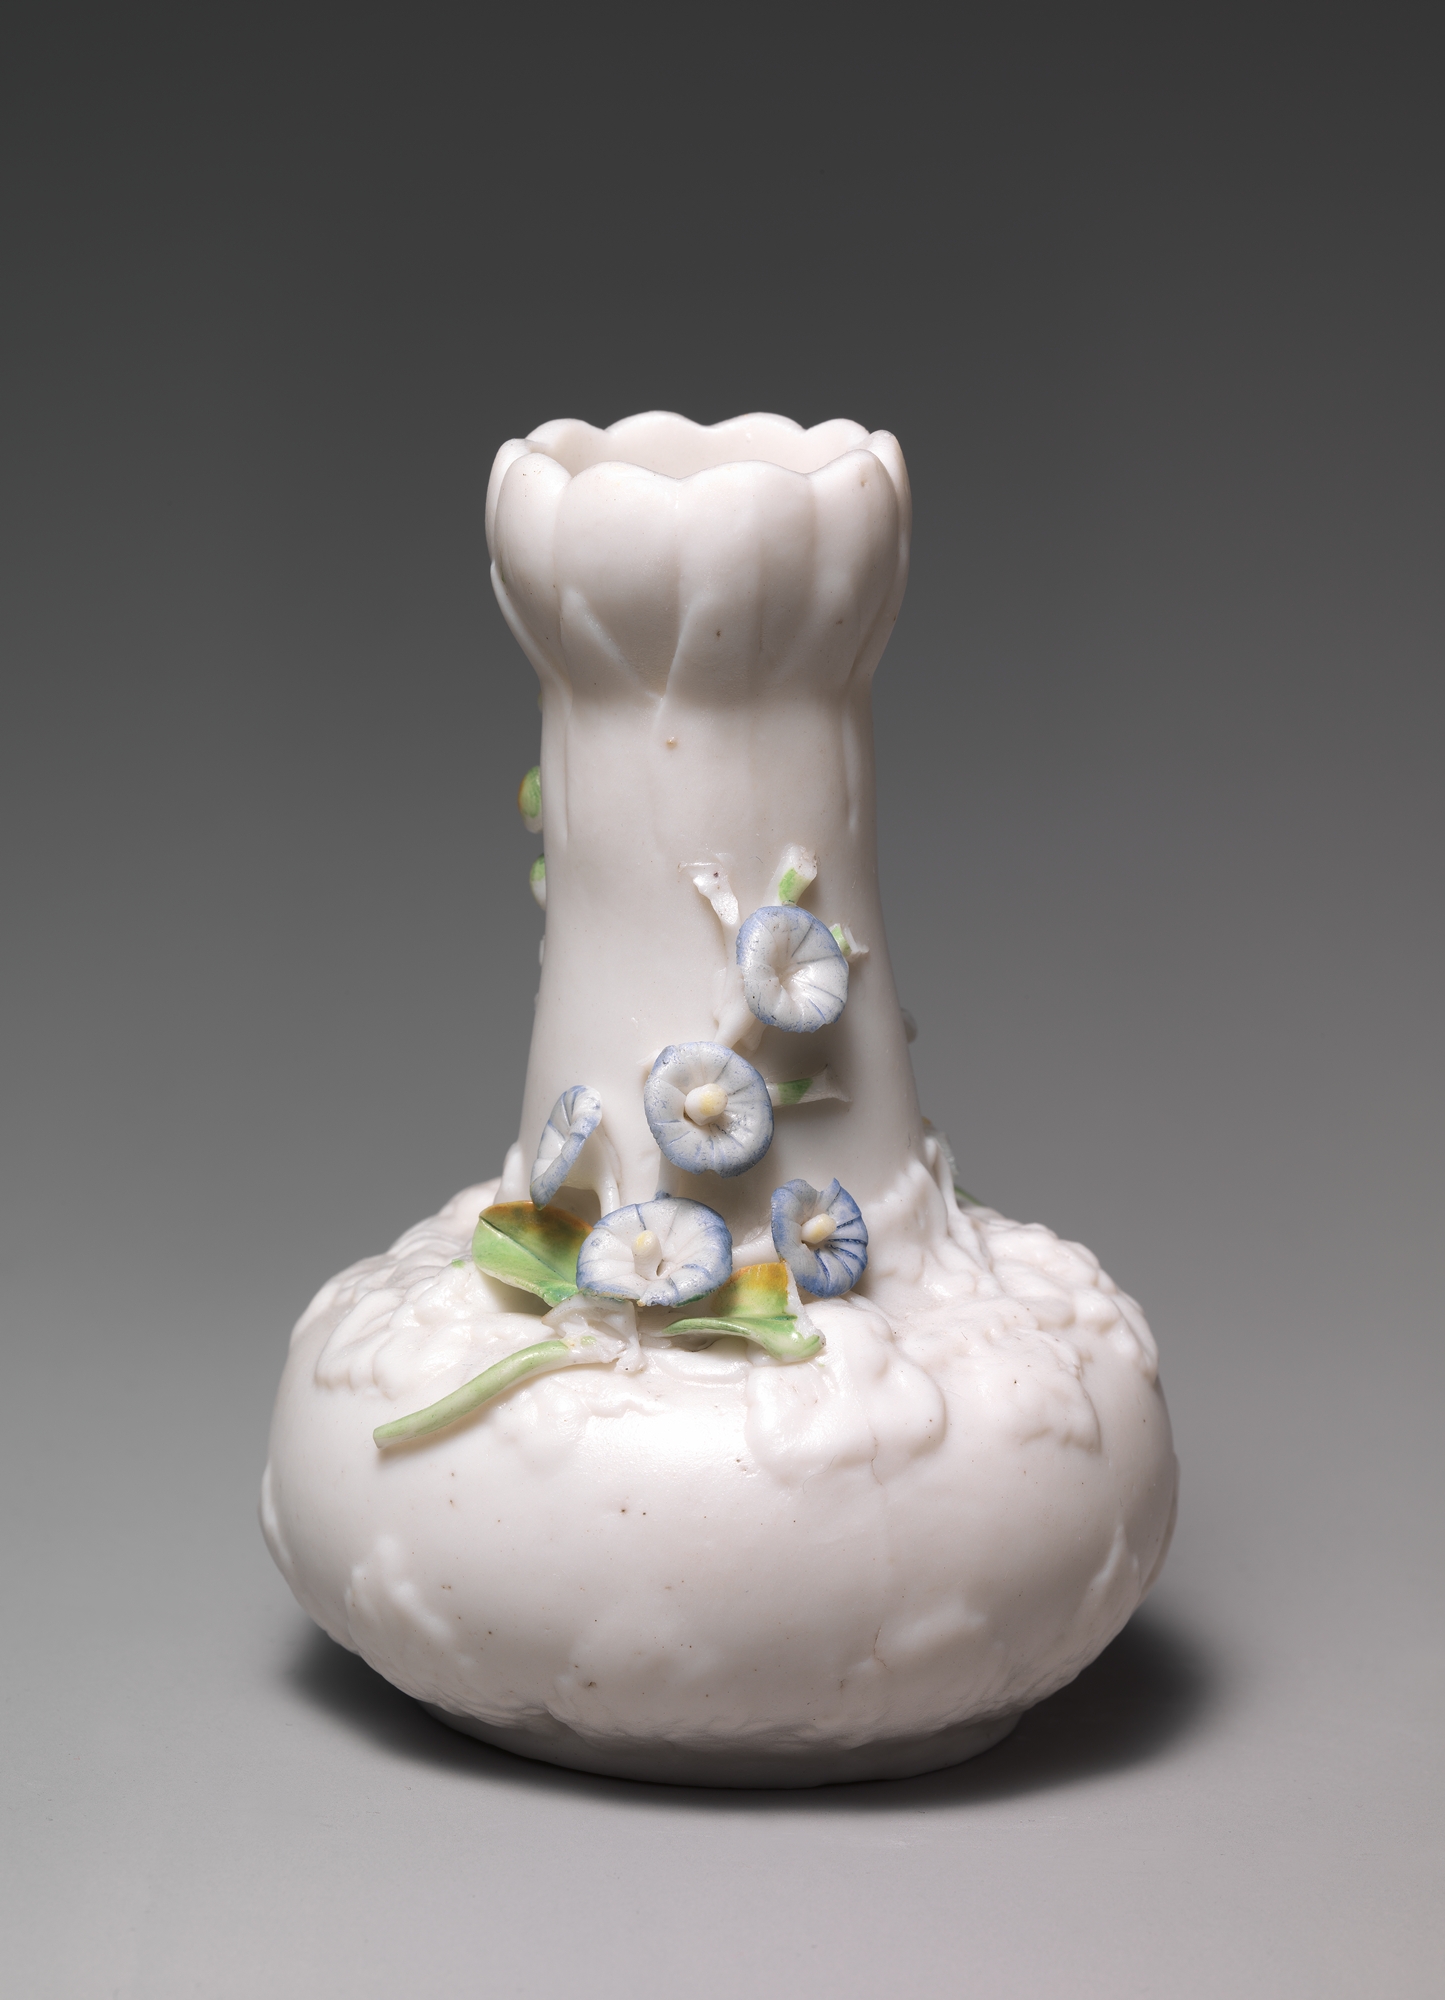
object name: perfume bottle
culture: american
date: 1830-1870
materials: porcelain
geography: united states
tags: flowers